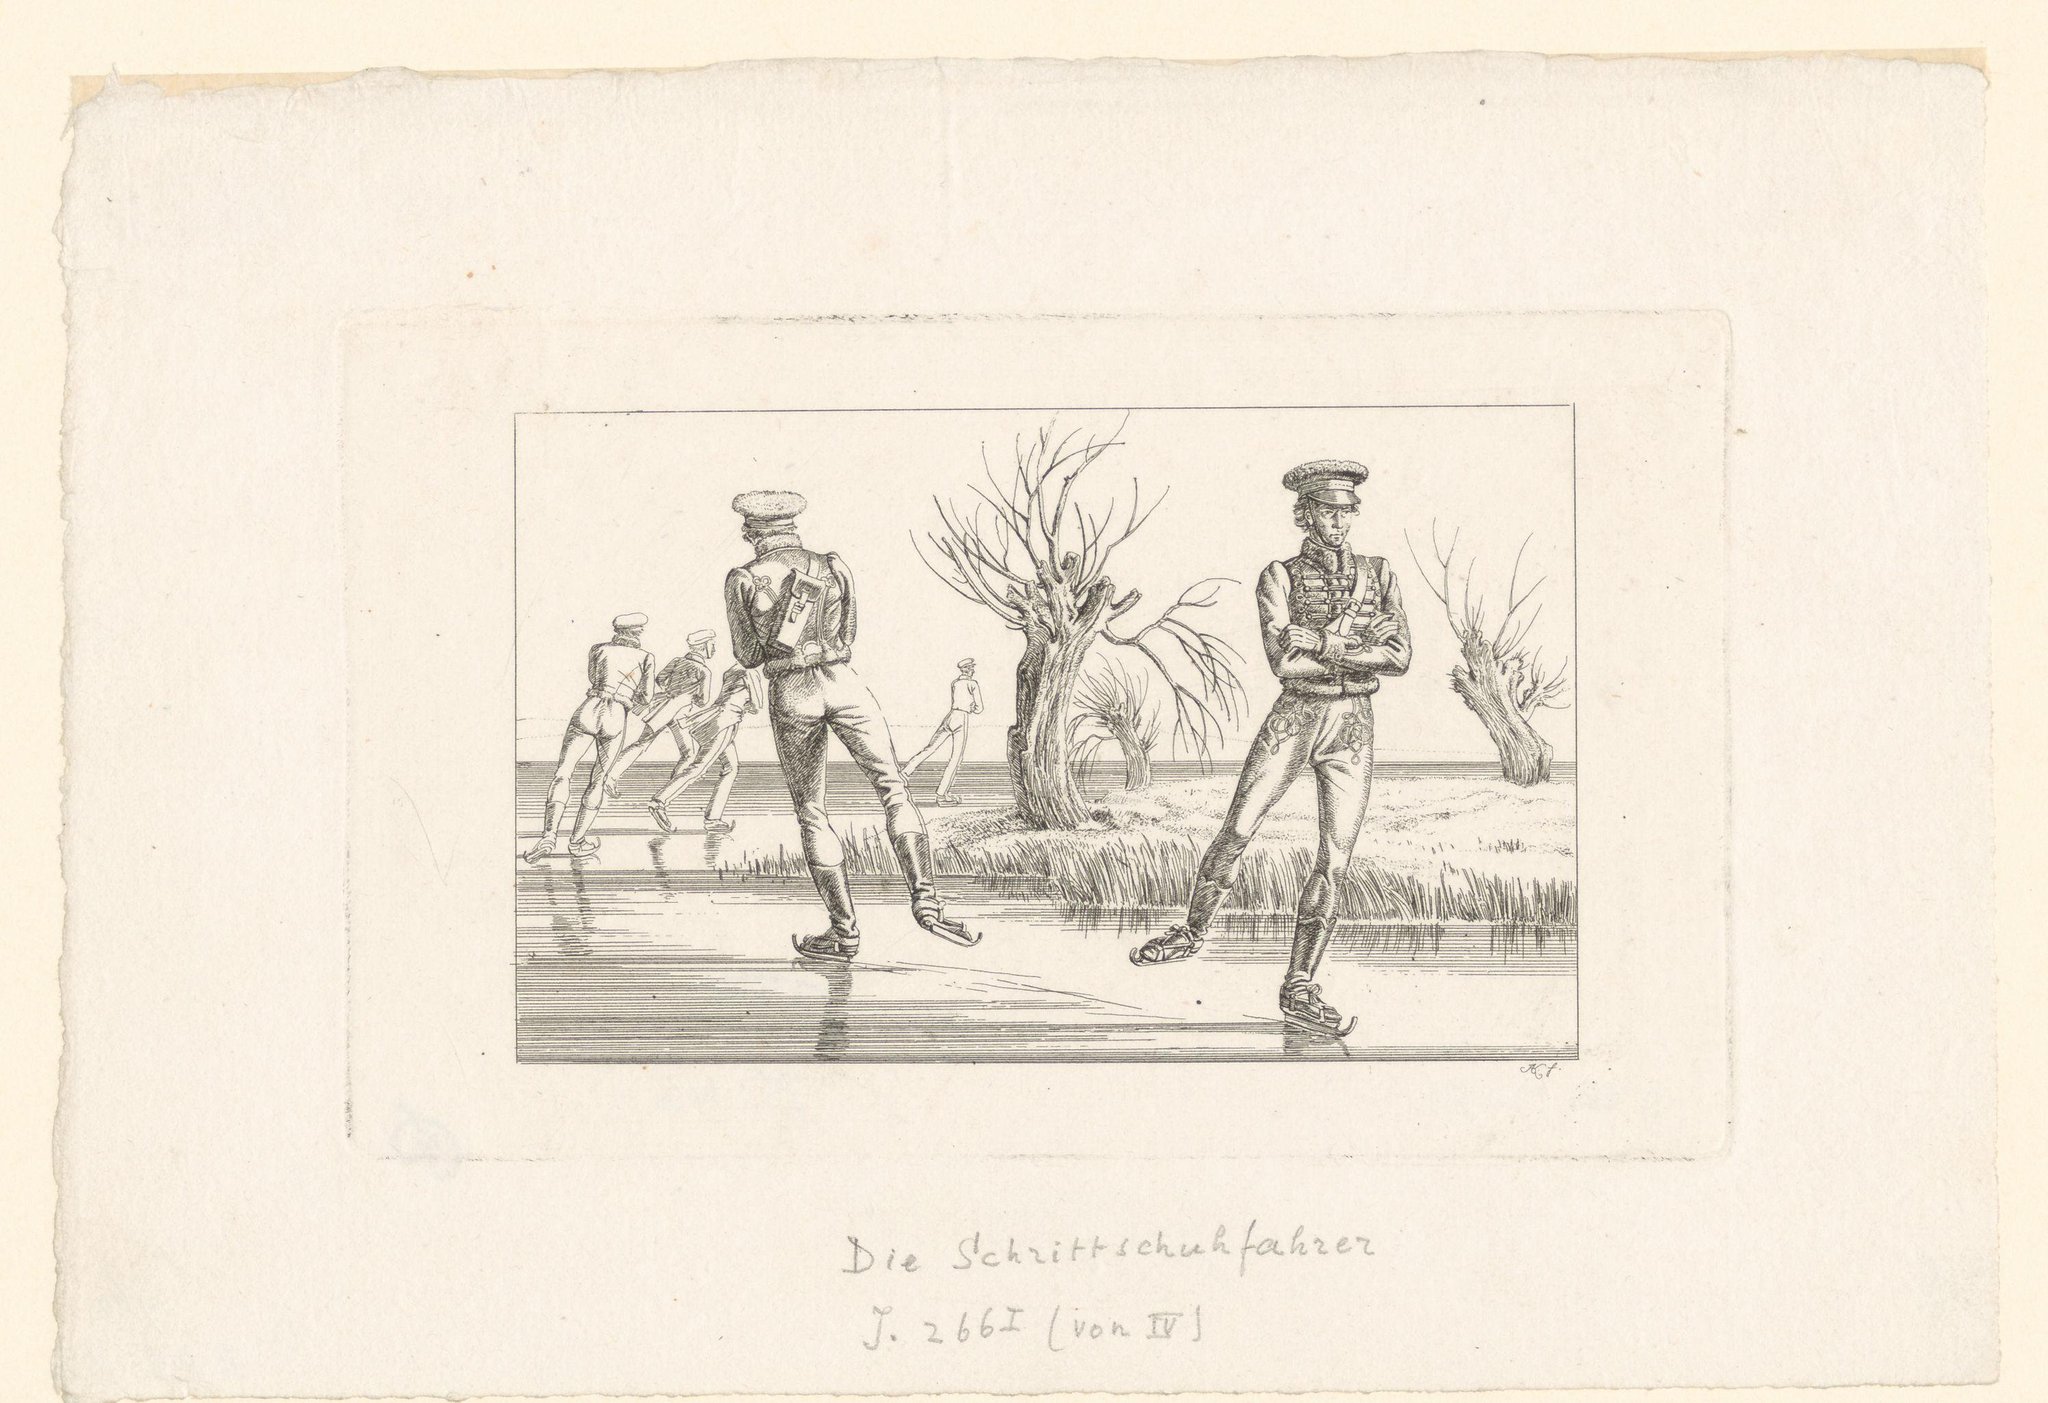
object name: print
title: Der Schrittenschuhfahrer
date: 1825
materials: paper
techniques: etching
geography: nuremberg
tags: skates (winter sports)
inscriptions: collector's mark: Lugt 4731, collector's mark: Lugt 2228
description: Prent is waarschijnlijk gebruikt in: Zindel, Christian Siegmund, Klopstock, Friedrich Gottlieb, Klein, Johann Adam. Der Eislauf oder das Schrittschuhfahren, ein Taschenbuch für Jung und Alt. Mit Gedichten von Klopstock, Goethe, Herder, Cramer, Krummacher etc: und Kupfern von J.A. Klein. Neurenberg: Friedrich Campe, 1825.